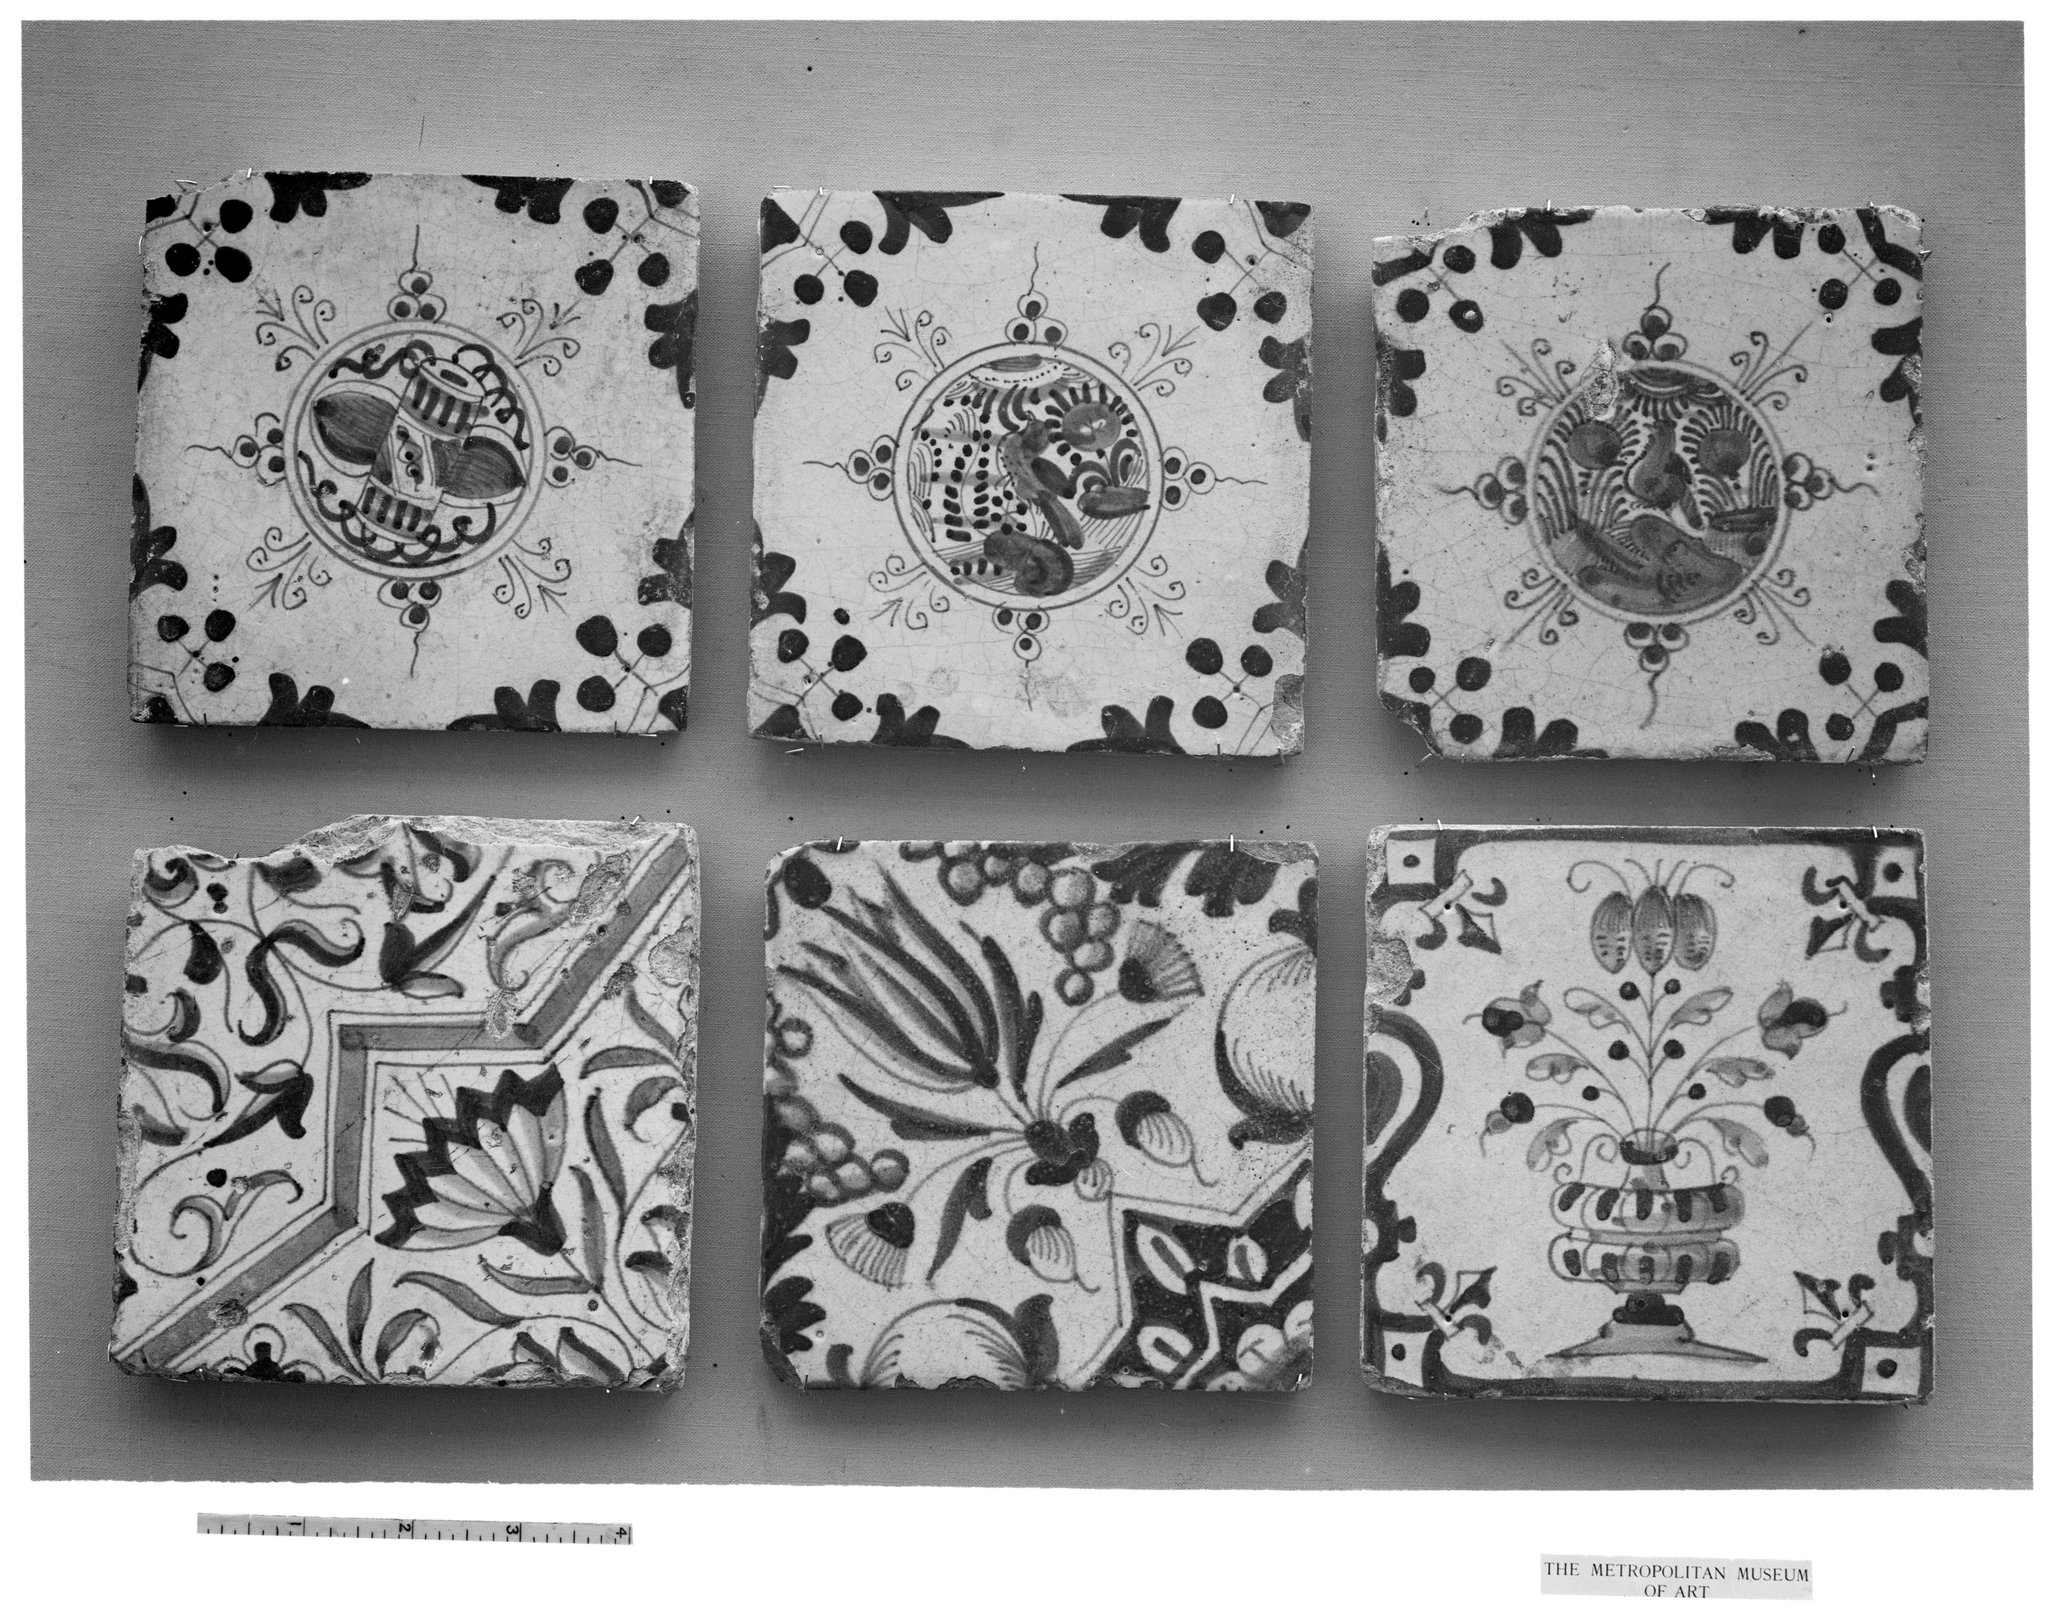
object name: tile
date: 1640-1660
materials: earthenware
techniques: glazing